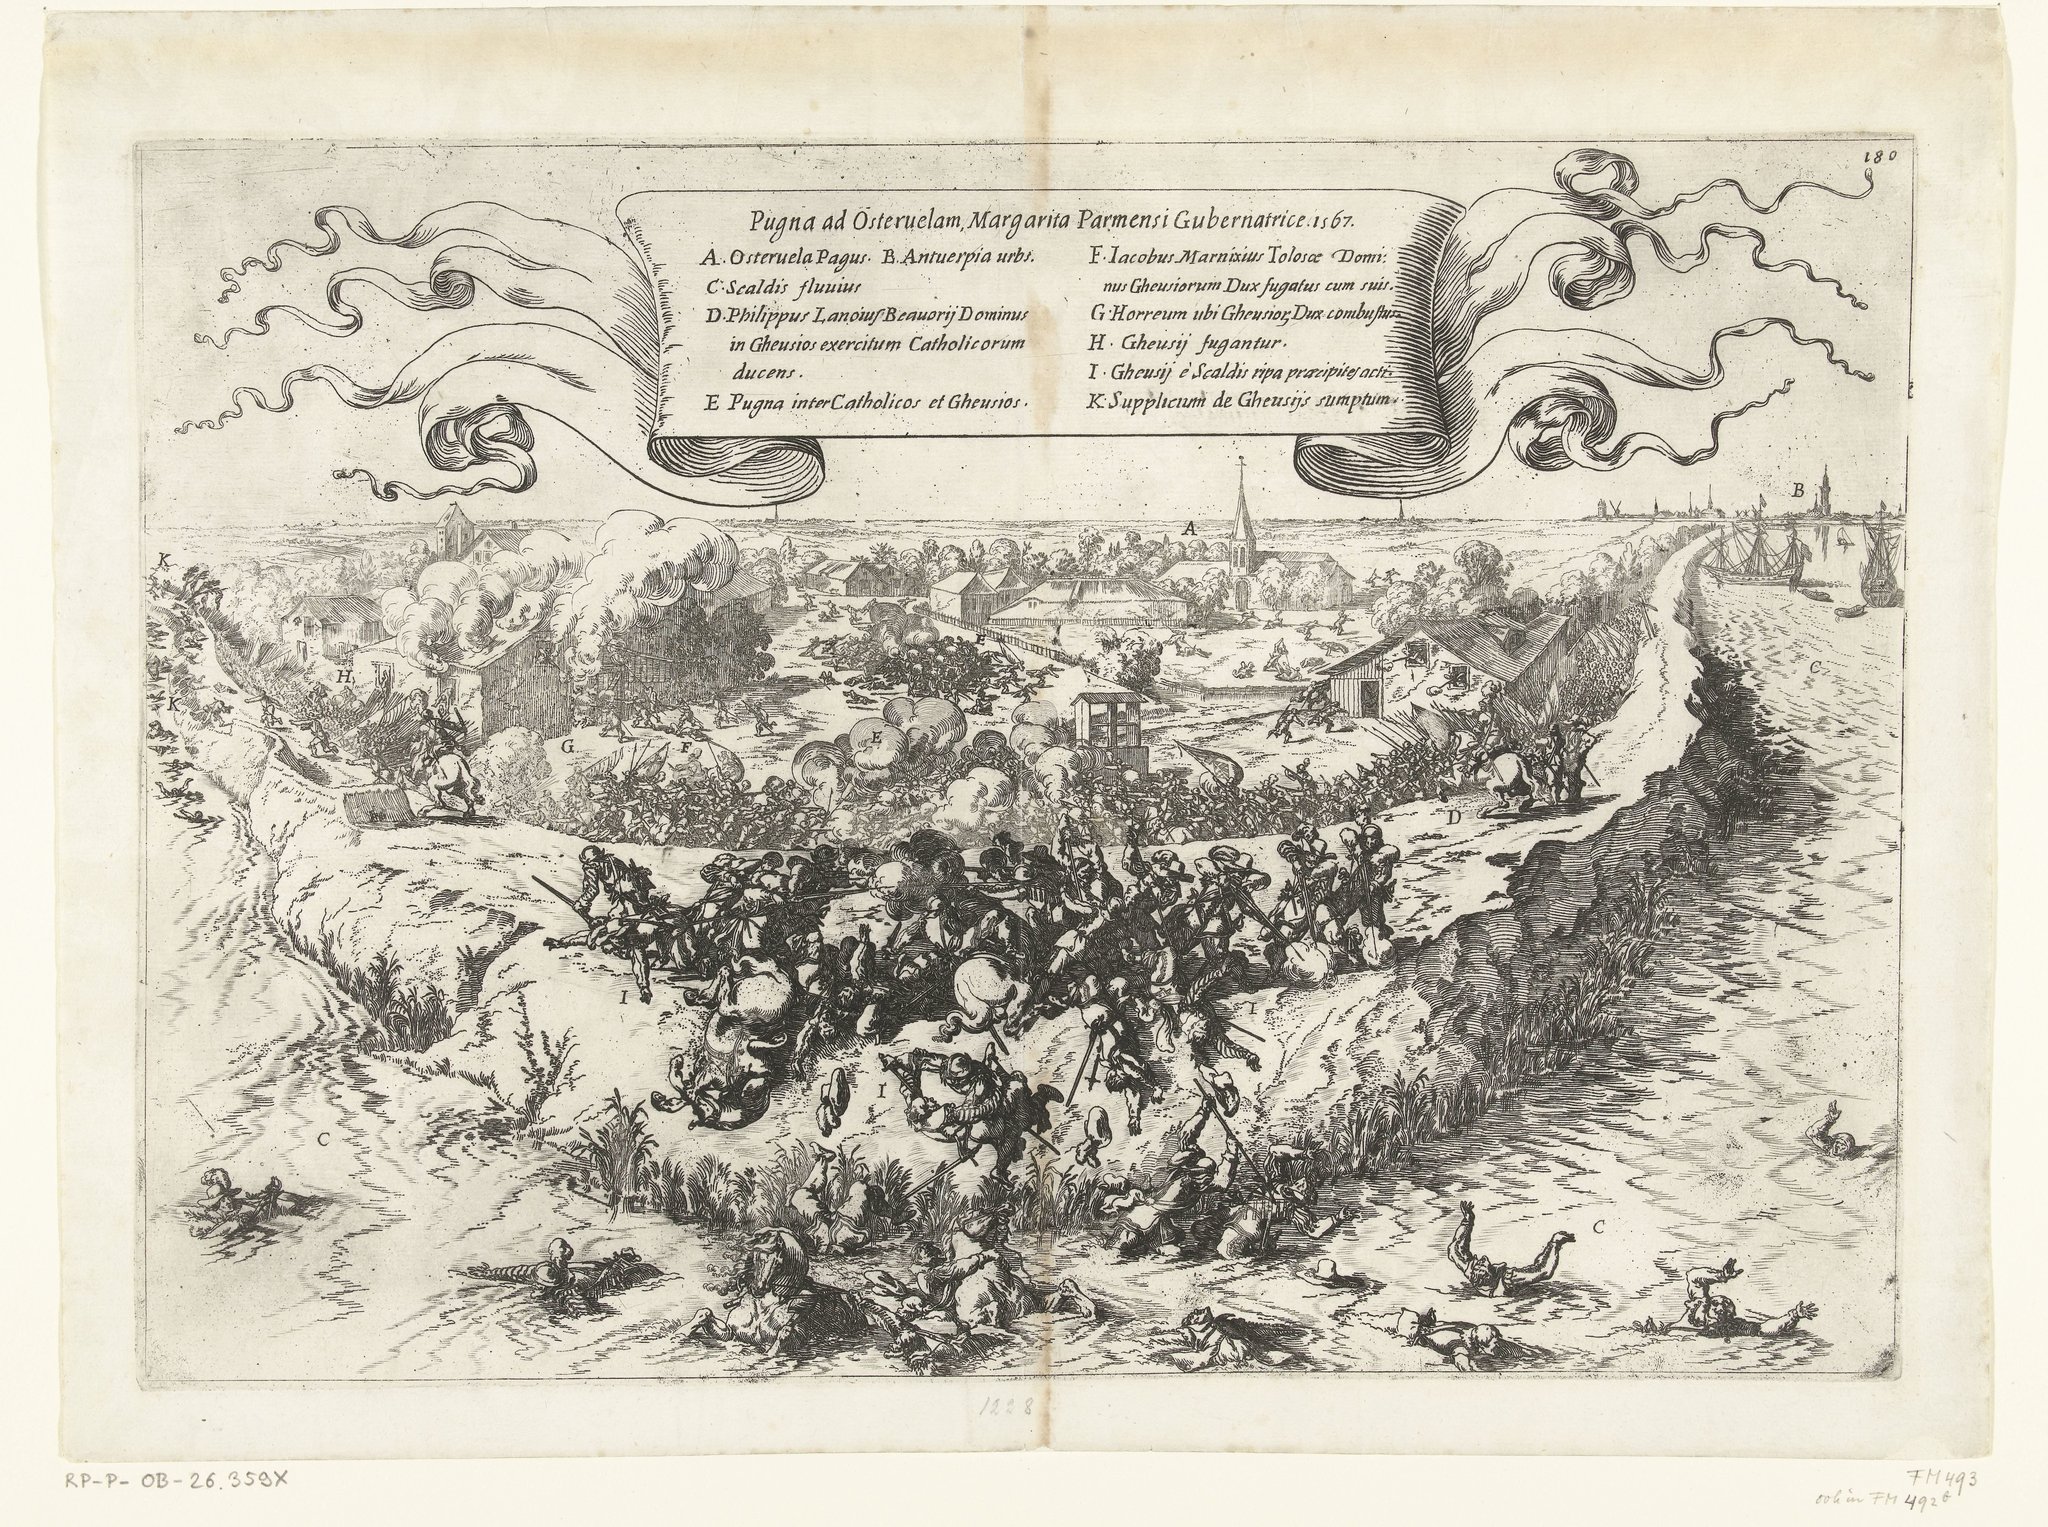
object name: print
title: Pugna ad Osteruelam, Margarita Parmensi Gubernatrice. 1567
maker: johann wilhelm baur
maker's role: draughtsman, painter, print maker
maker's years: 1607-1642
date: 1630-1632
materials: paper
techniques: etching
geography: rome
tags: battle, fighting in general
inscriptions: collector's mark: Lugt 2228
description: Slag bij Oosterweel, 13 maart 1567. De gevechten voor het dorpje Oosterweel buiten Antwerpen. De calvinisten onder leiding van Jan van Marnix worden verslagen door de troepen van de hertog van Aremberg en Philips van Lanoy. Rechts de Schelde. Bovenaan een banderol met de titel en de legenda A-K in het Latijn.